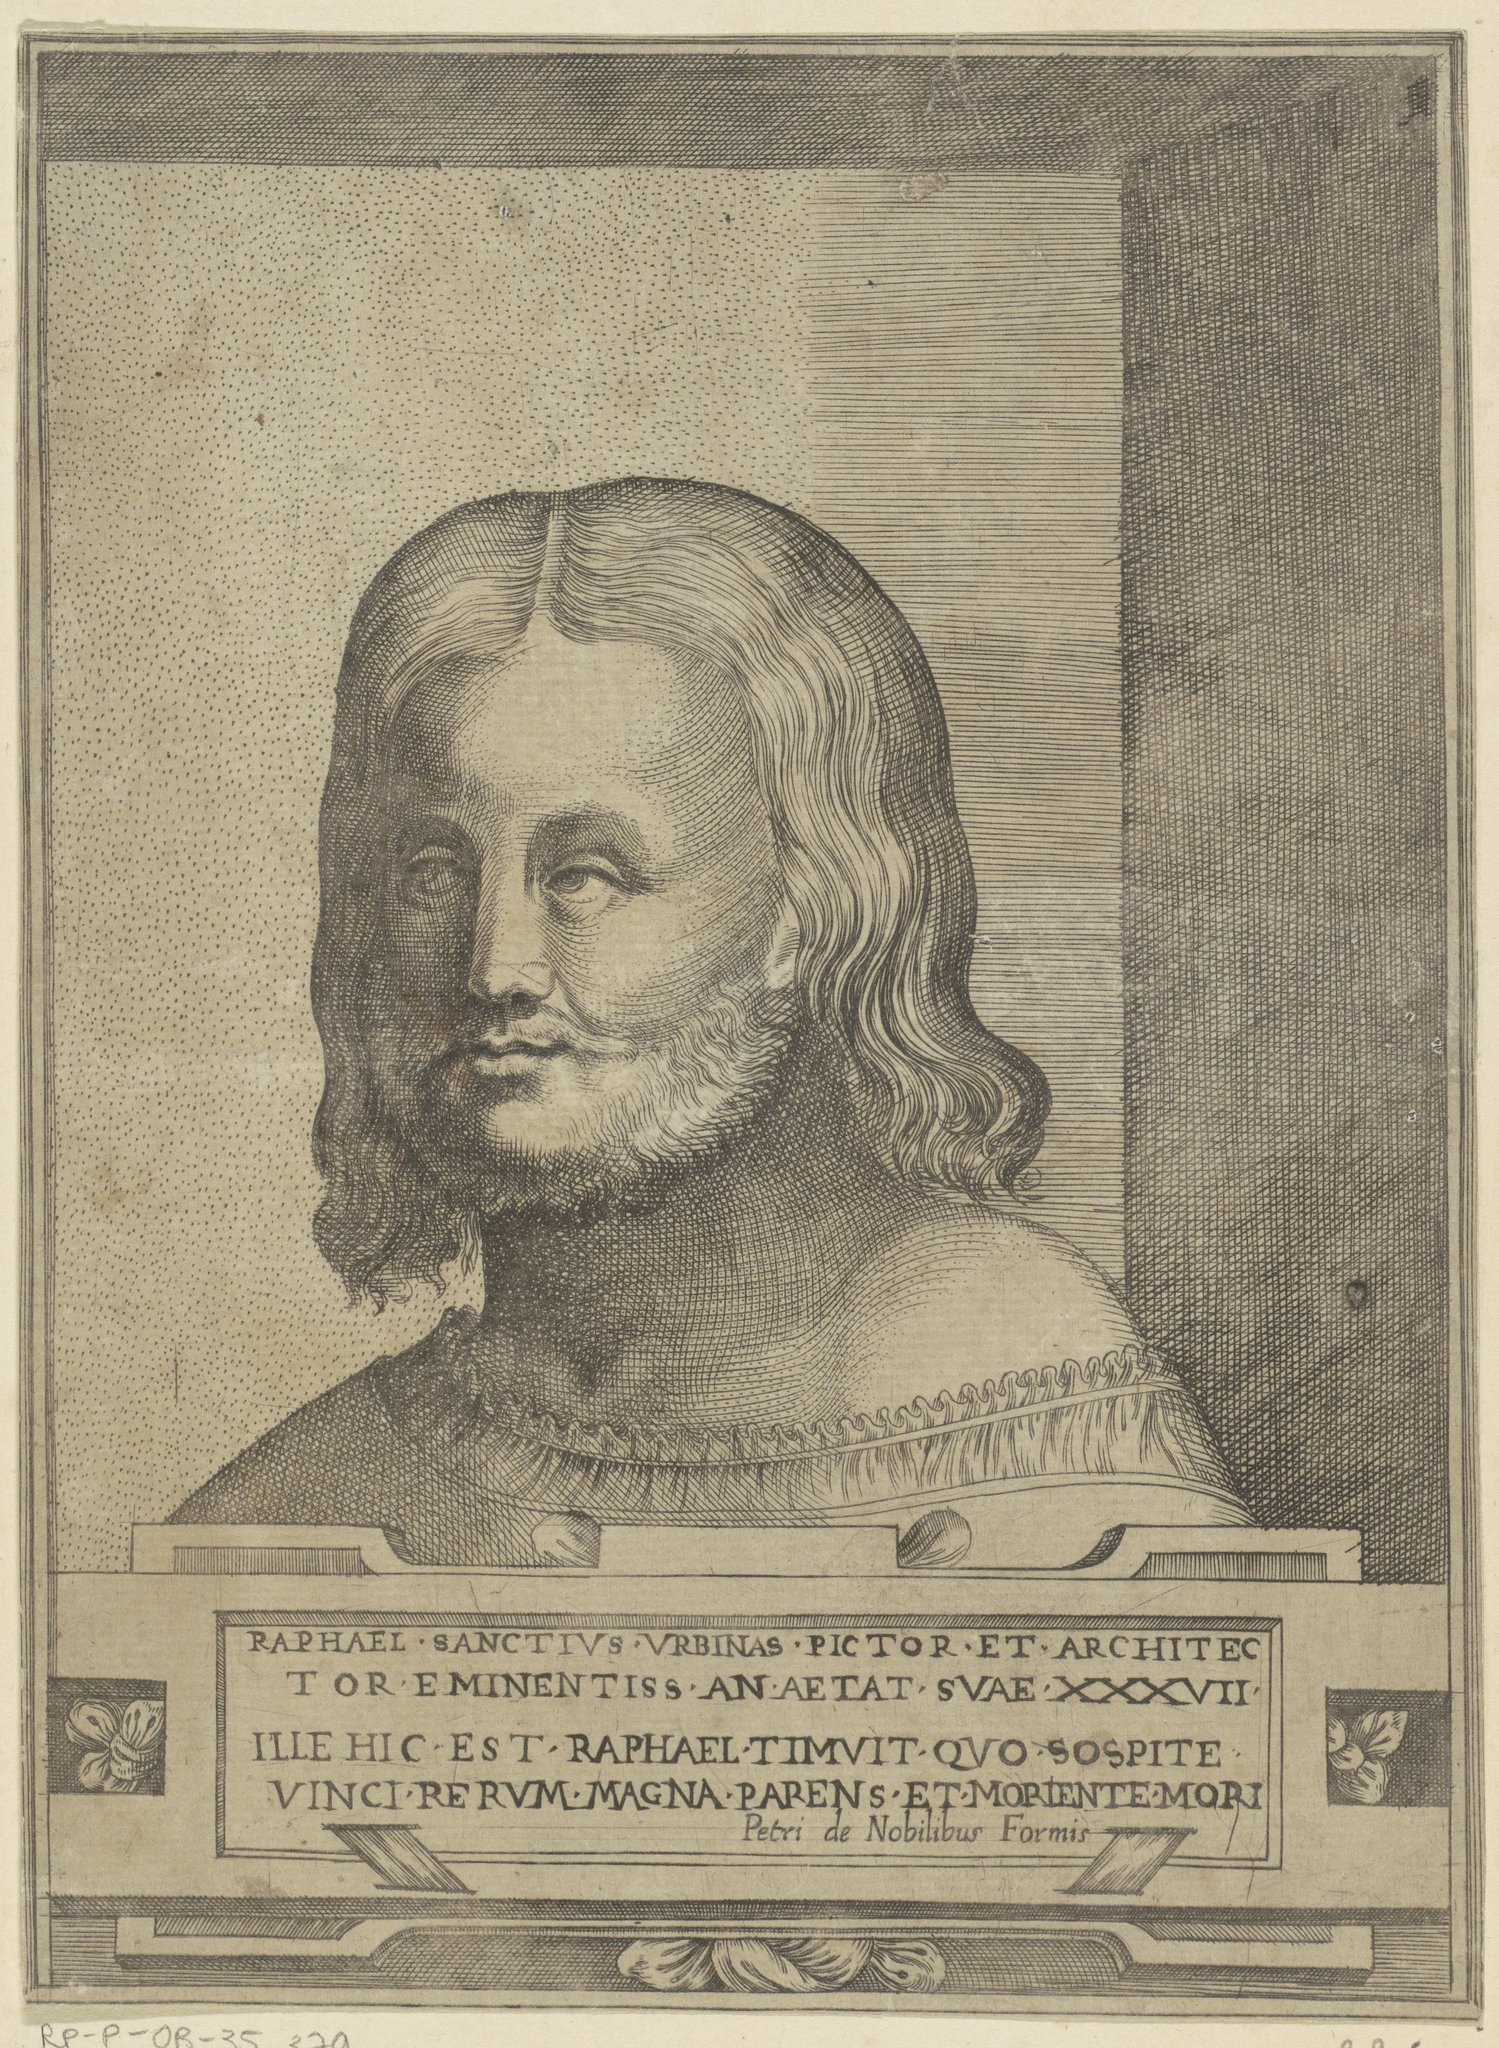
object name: print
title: Portret van de kunstenaar Rafaël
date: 1584-1585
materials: paper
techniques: etching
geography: italy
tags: rome, painter, rafaël, historical persons, portrait, self-portrait of artist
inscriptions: collector's mark: Lugt 240